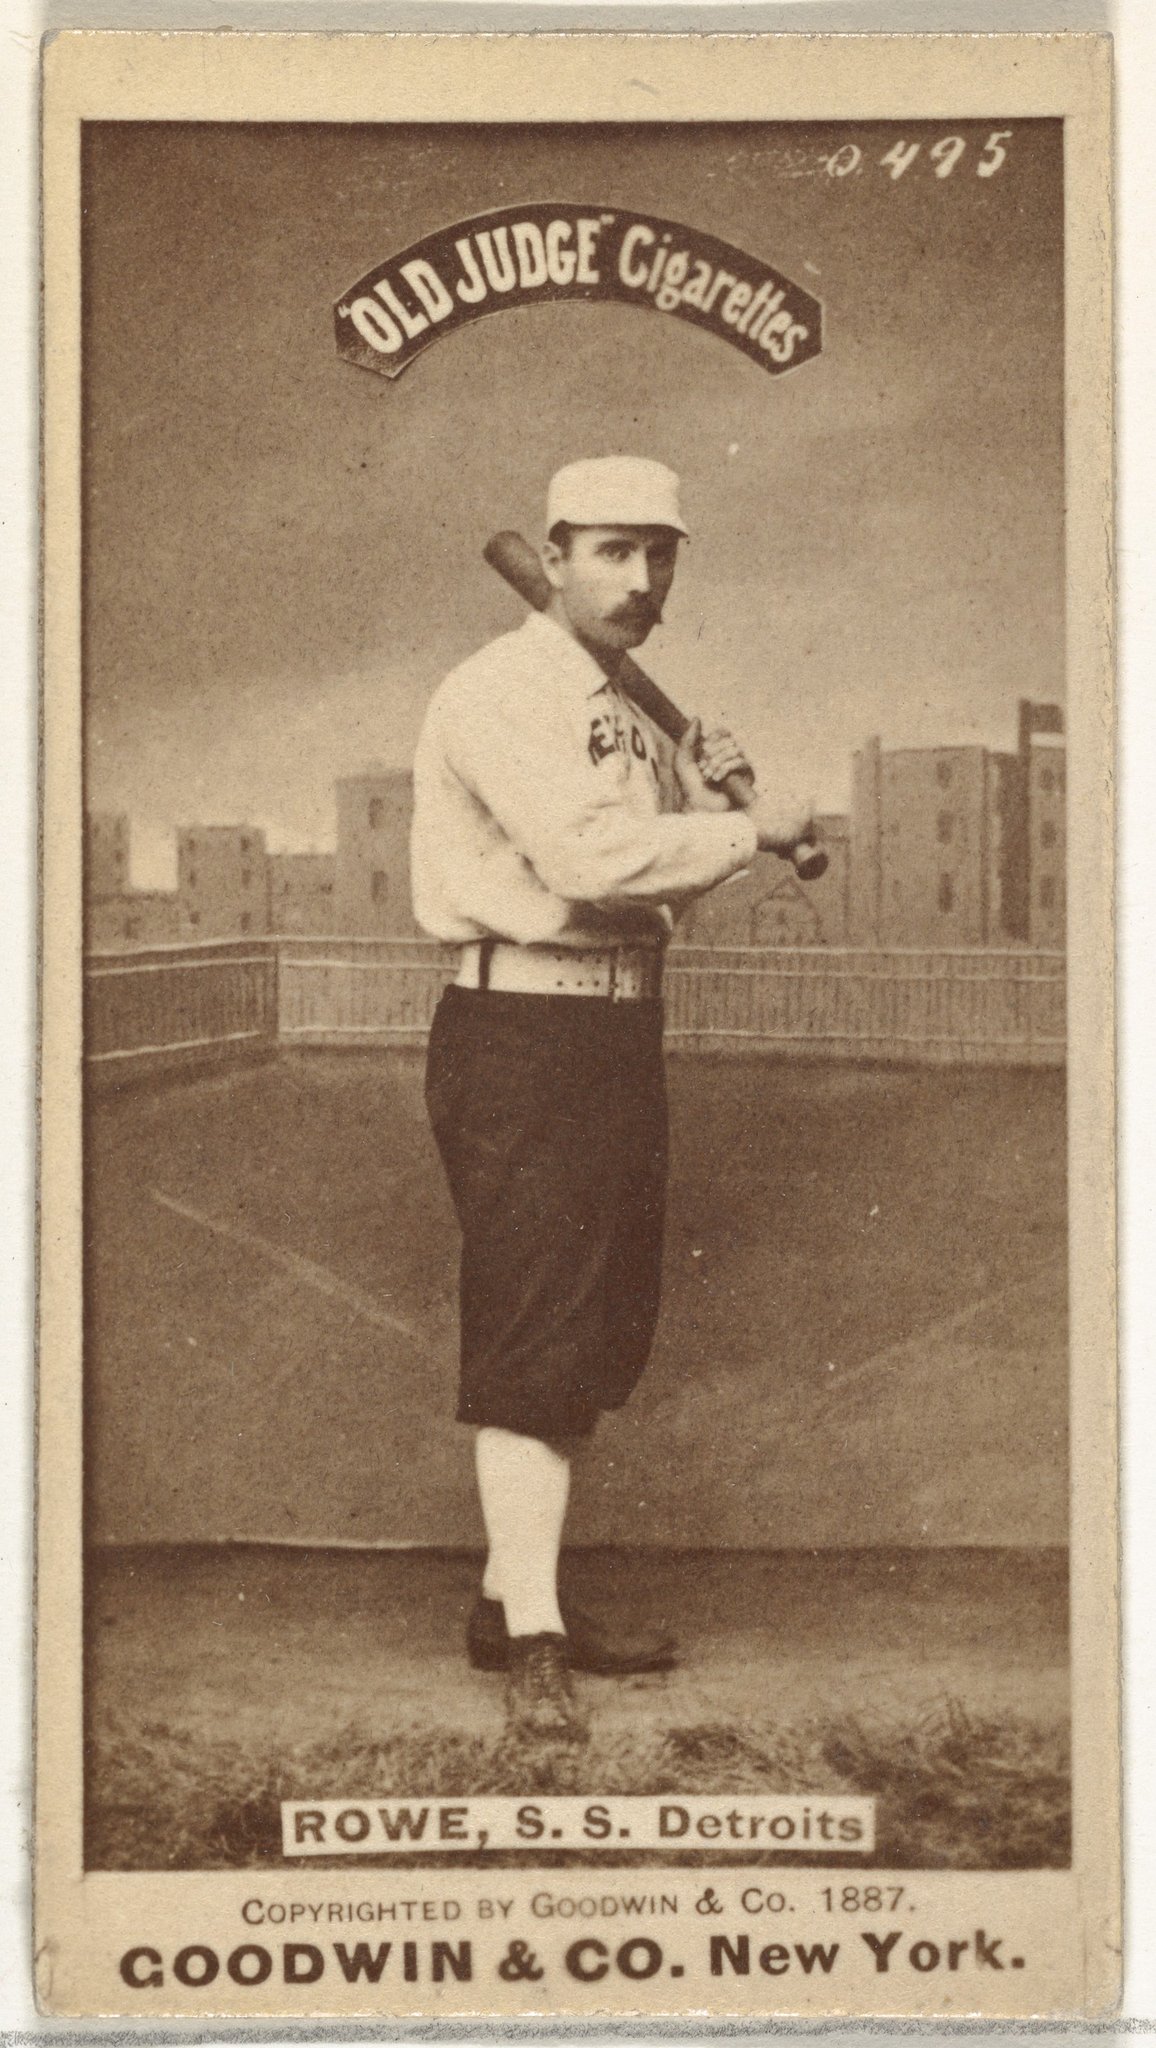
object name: baseball card, photograph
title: John Charles "Jack" Rowe, Shortstop, Detroit Wolverines, from the Old Judge series (N172) for Old Judge Cigarettes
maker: goodwin & company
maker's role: publisher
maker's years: 1850-1950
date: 1887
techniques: albumen silver print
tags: men,portraits,baseball,athletes